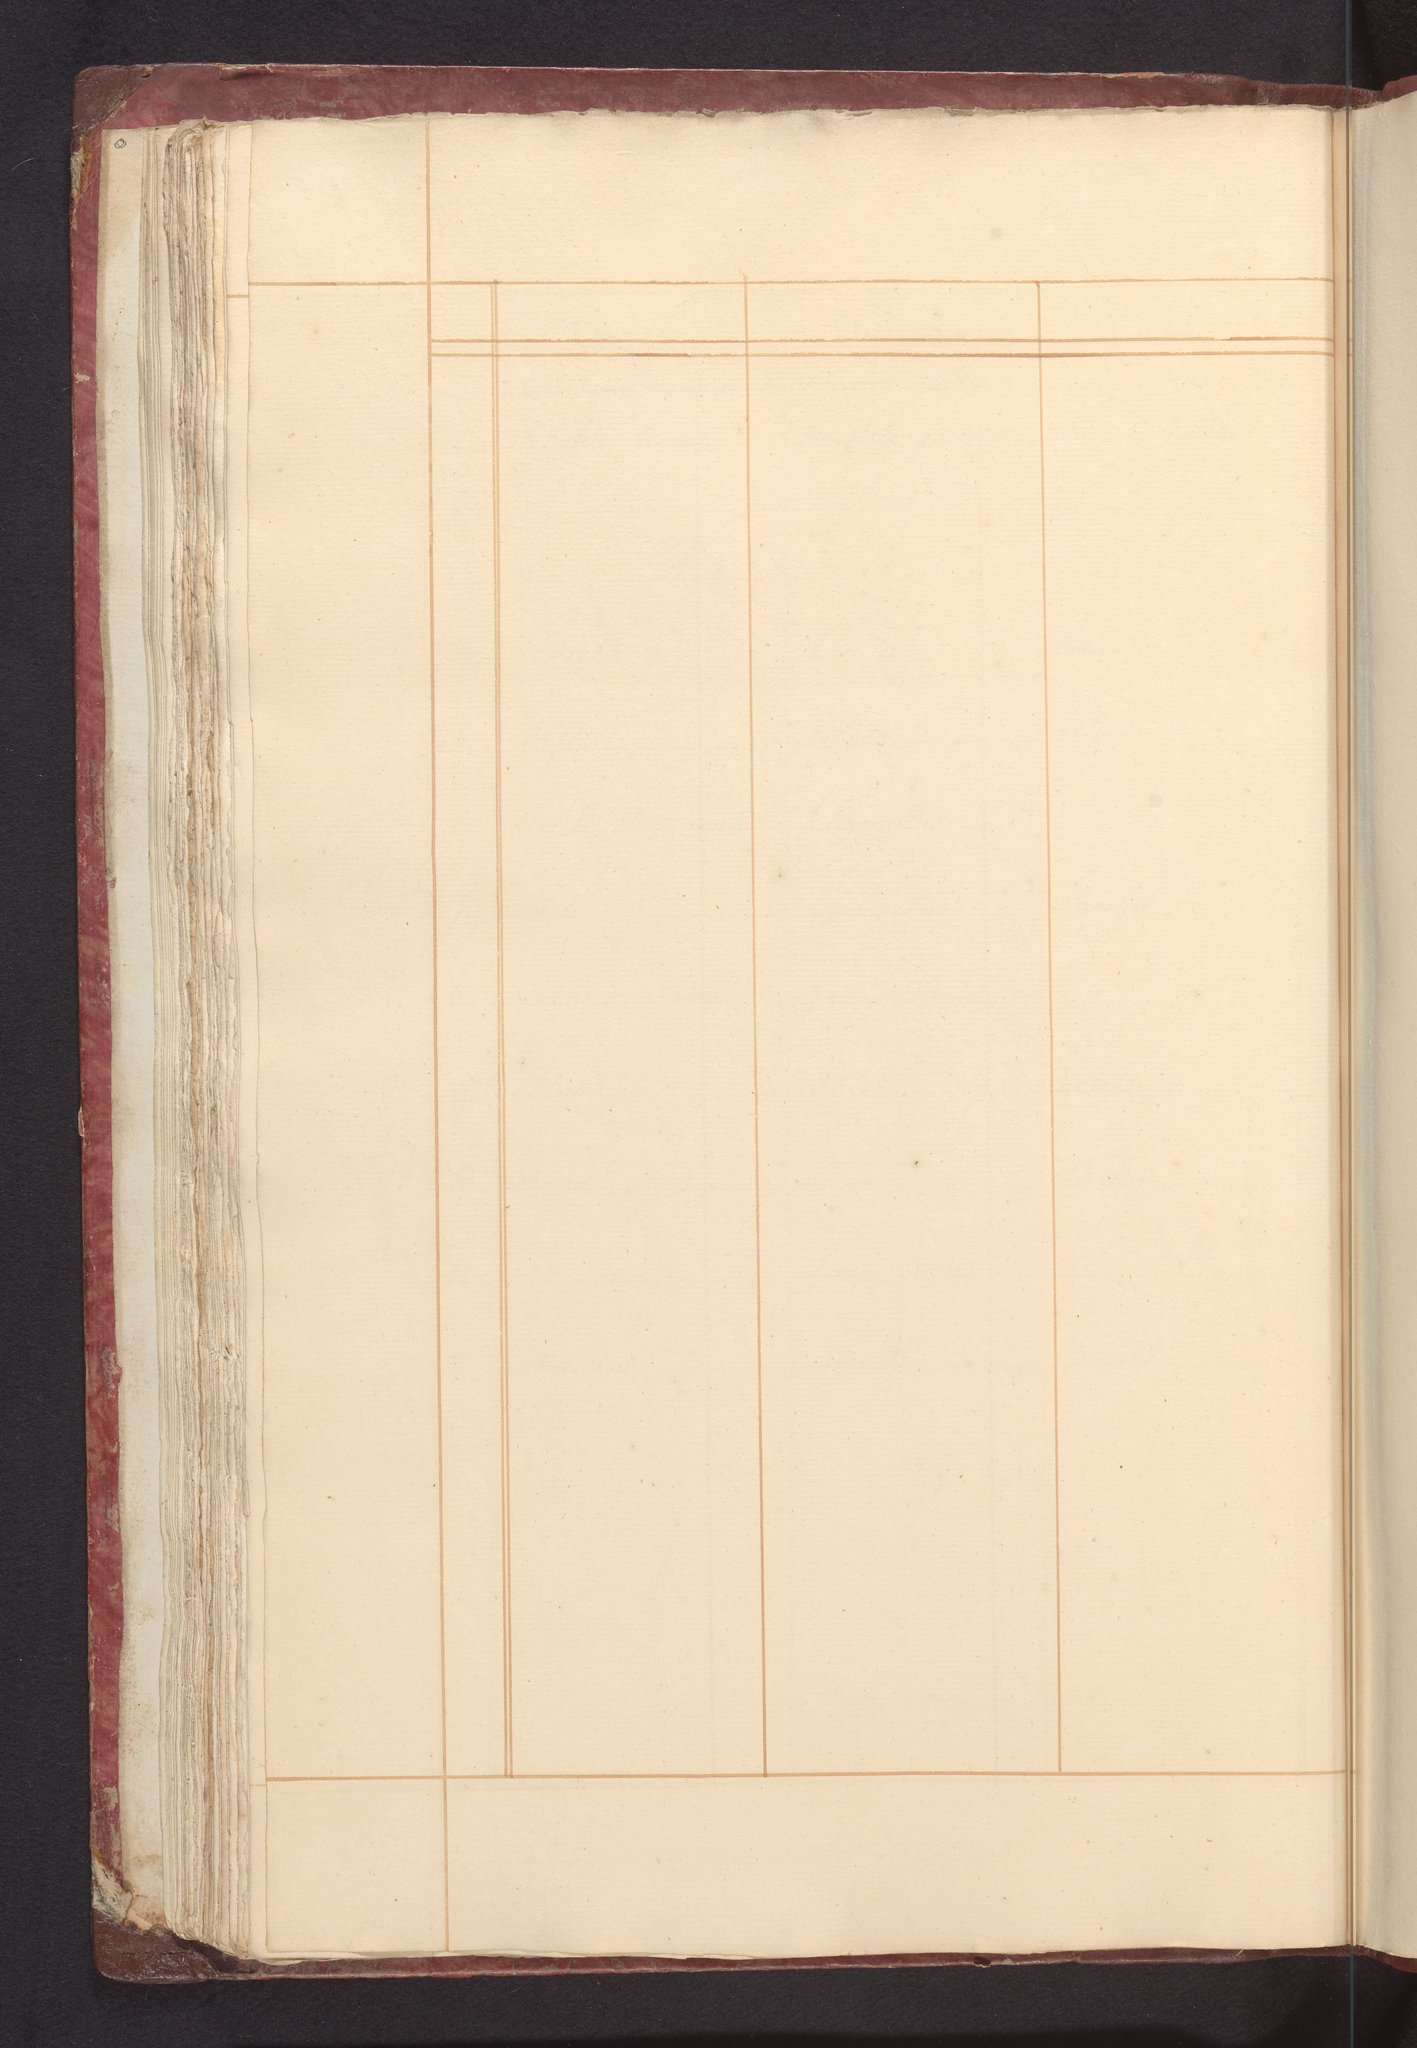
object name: manuscript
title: Oningevuld schema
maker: joseph van huerne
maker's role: kunstliefhebber, mecenas, verzamelaar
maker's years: 1752-1844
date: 1809-1814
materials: ink, paper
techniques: pen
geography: bruges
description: Oningevuld schema met drie kolommen. Onderdeel van het zesde album met tekeningen van vissen, schelpen en insekten. Zesde van twaalf albums met tekeningen van dieren, vogels en planten bekend rond 1600, gemaakt in opdracht van keizer Rudolf II. Met toelichting in Nederlands, Latijn en Frans.